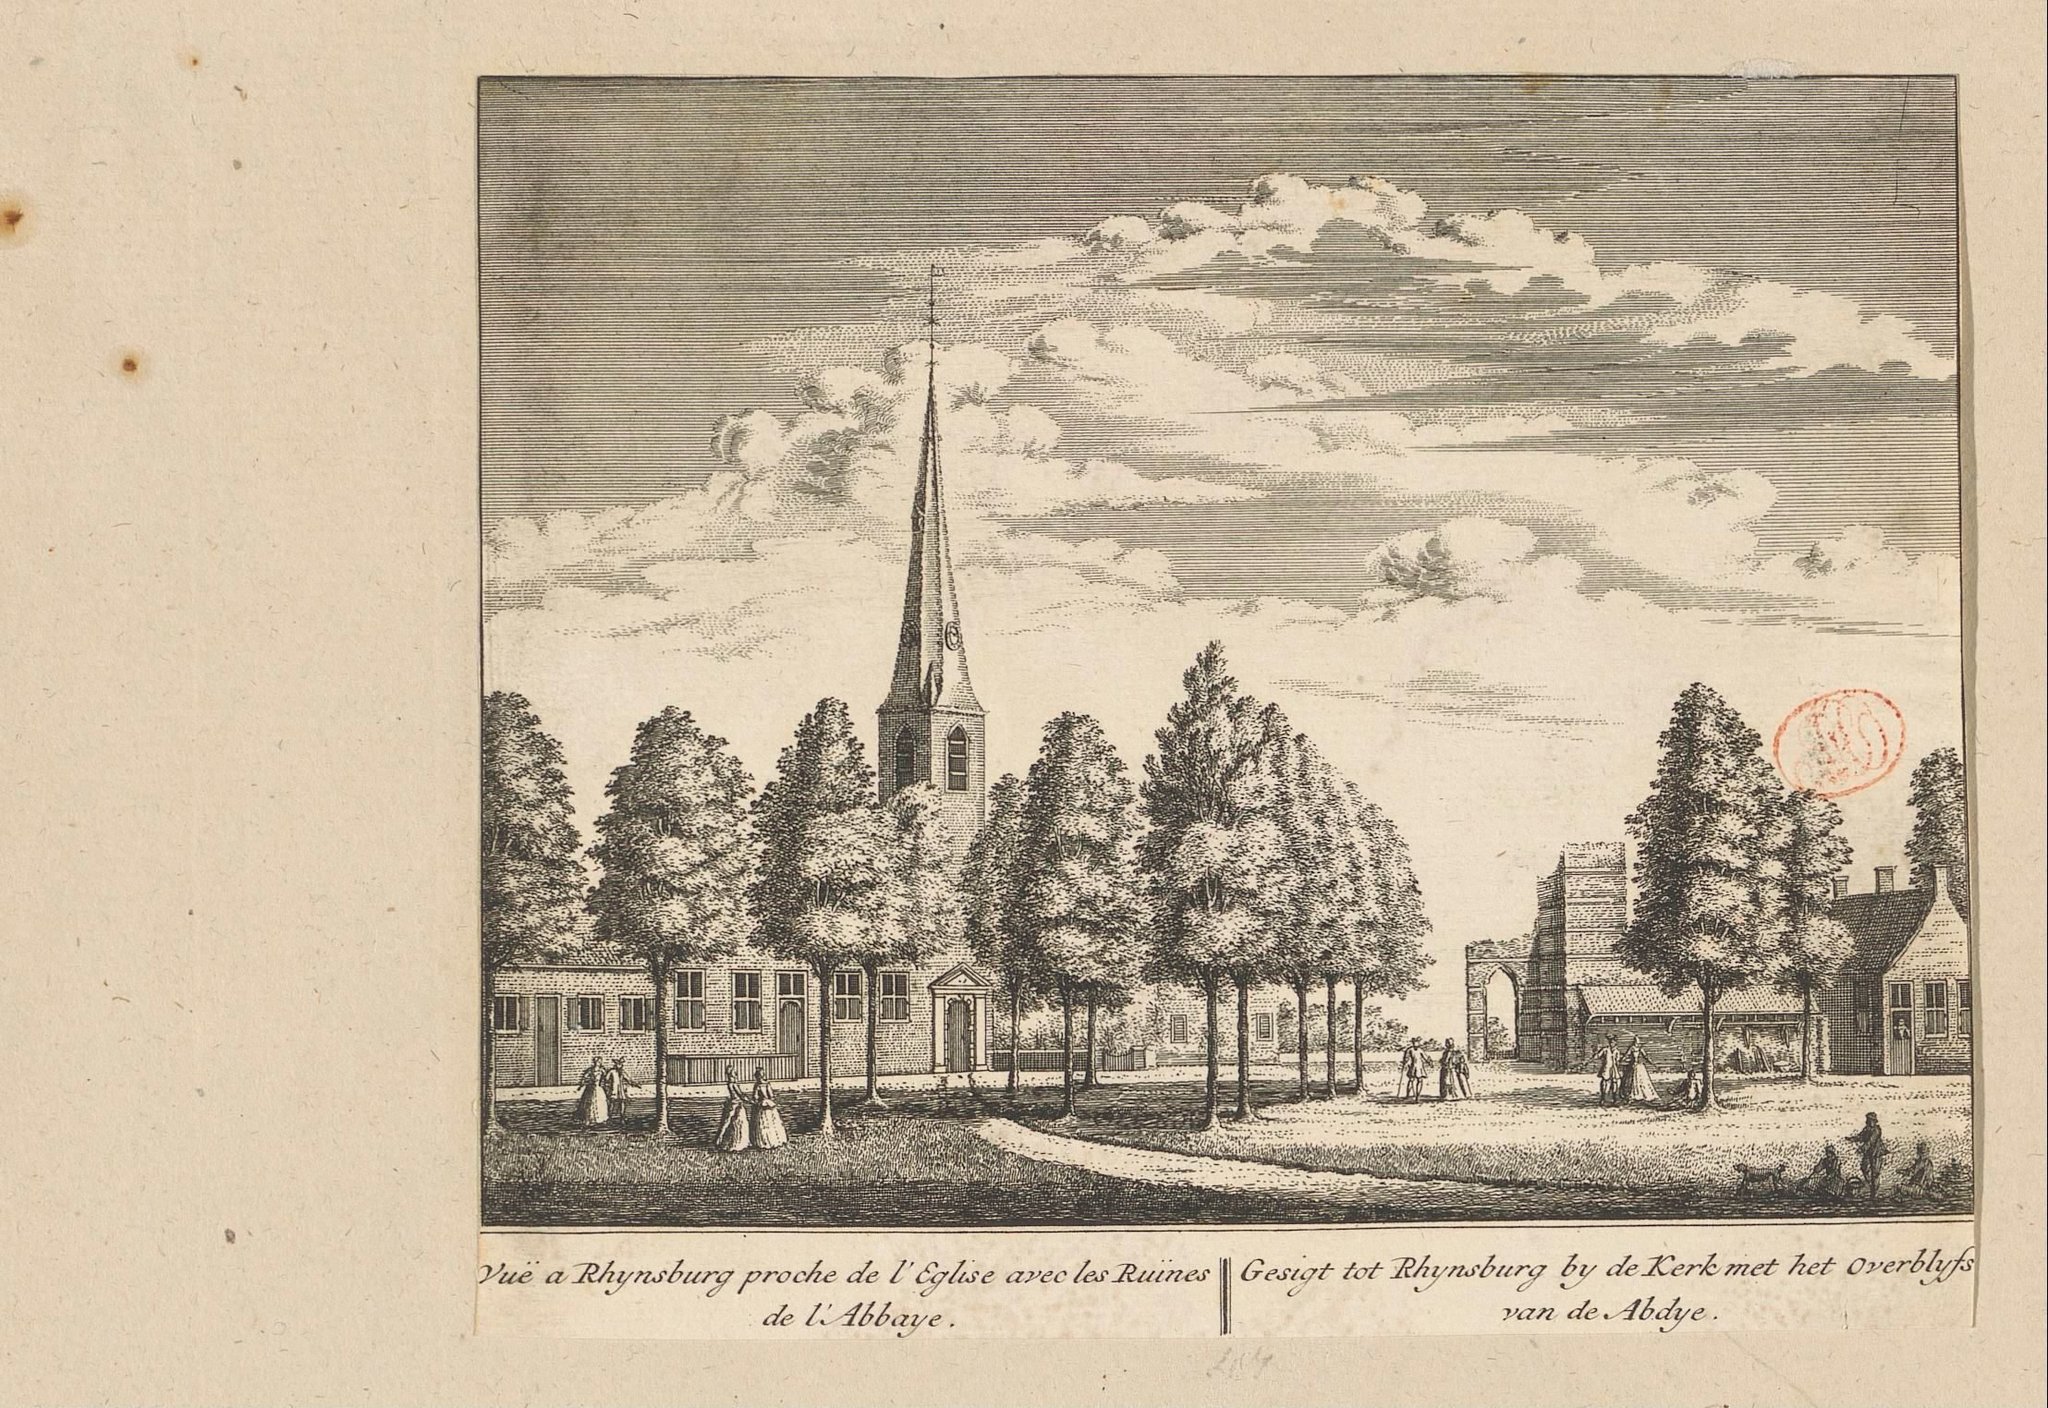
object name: print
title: Gesigt tot Rhynsburg by de kerk met het overblyfs van de abdye / Vuë a Rhynsburg proche de l'eglise avec les ruïnes de l'abbaye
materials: paper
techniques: etching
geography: amsterdam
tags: church (exterior), ruin of church, monastery, etc.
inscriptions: collector's mark: Lugt 195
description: Prent ook gebruikt in: Rademaker, Abraham. Rhynlands fraaiste gezichten; vertonende alle deszelfs lustplaatzen, heeren-huizen en dorpen. Van halfwegen Haarlem en Leyden (…) / Les plus agréables vuës de Rhynland, representant toutes les maisons de plaisance, maisons seigneuriales & villages. Commençant à demilieu Haarlem & Leyden (…). Ansterdam: Leonard Schenk, 1732.